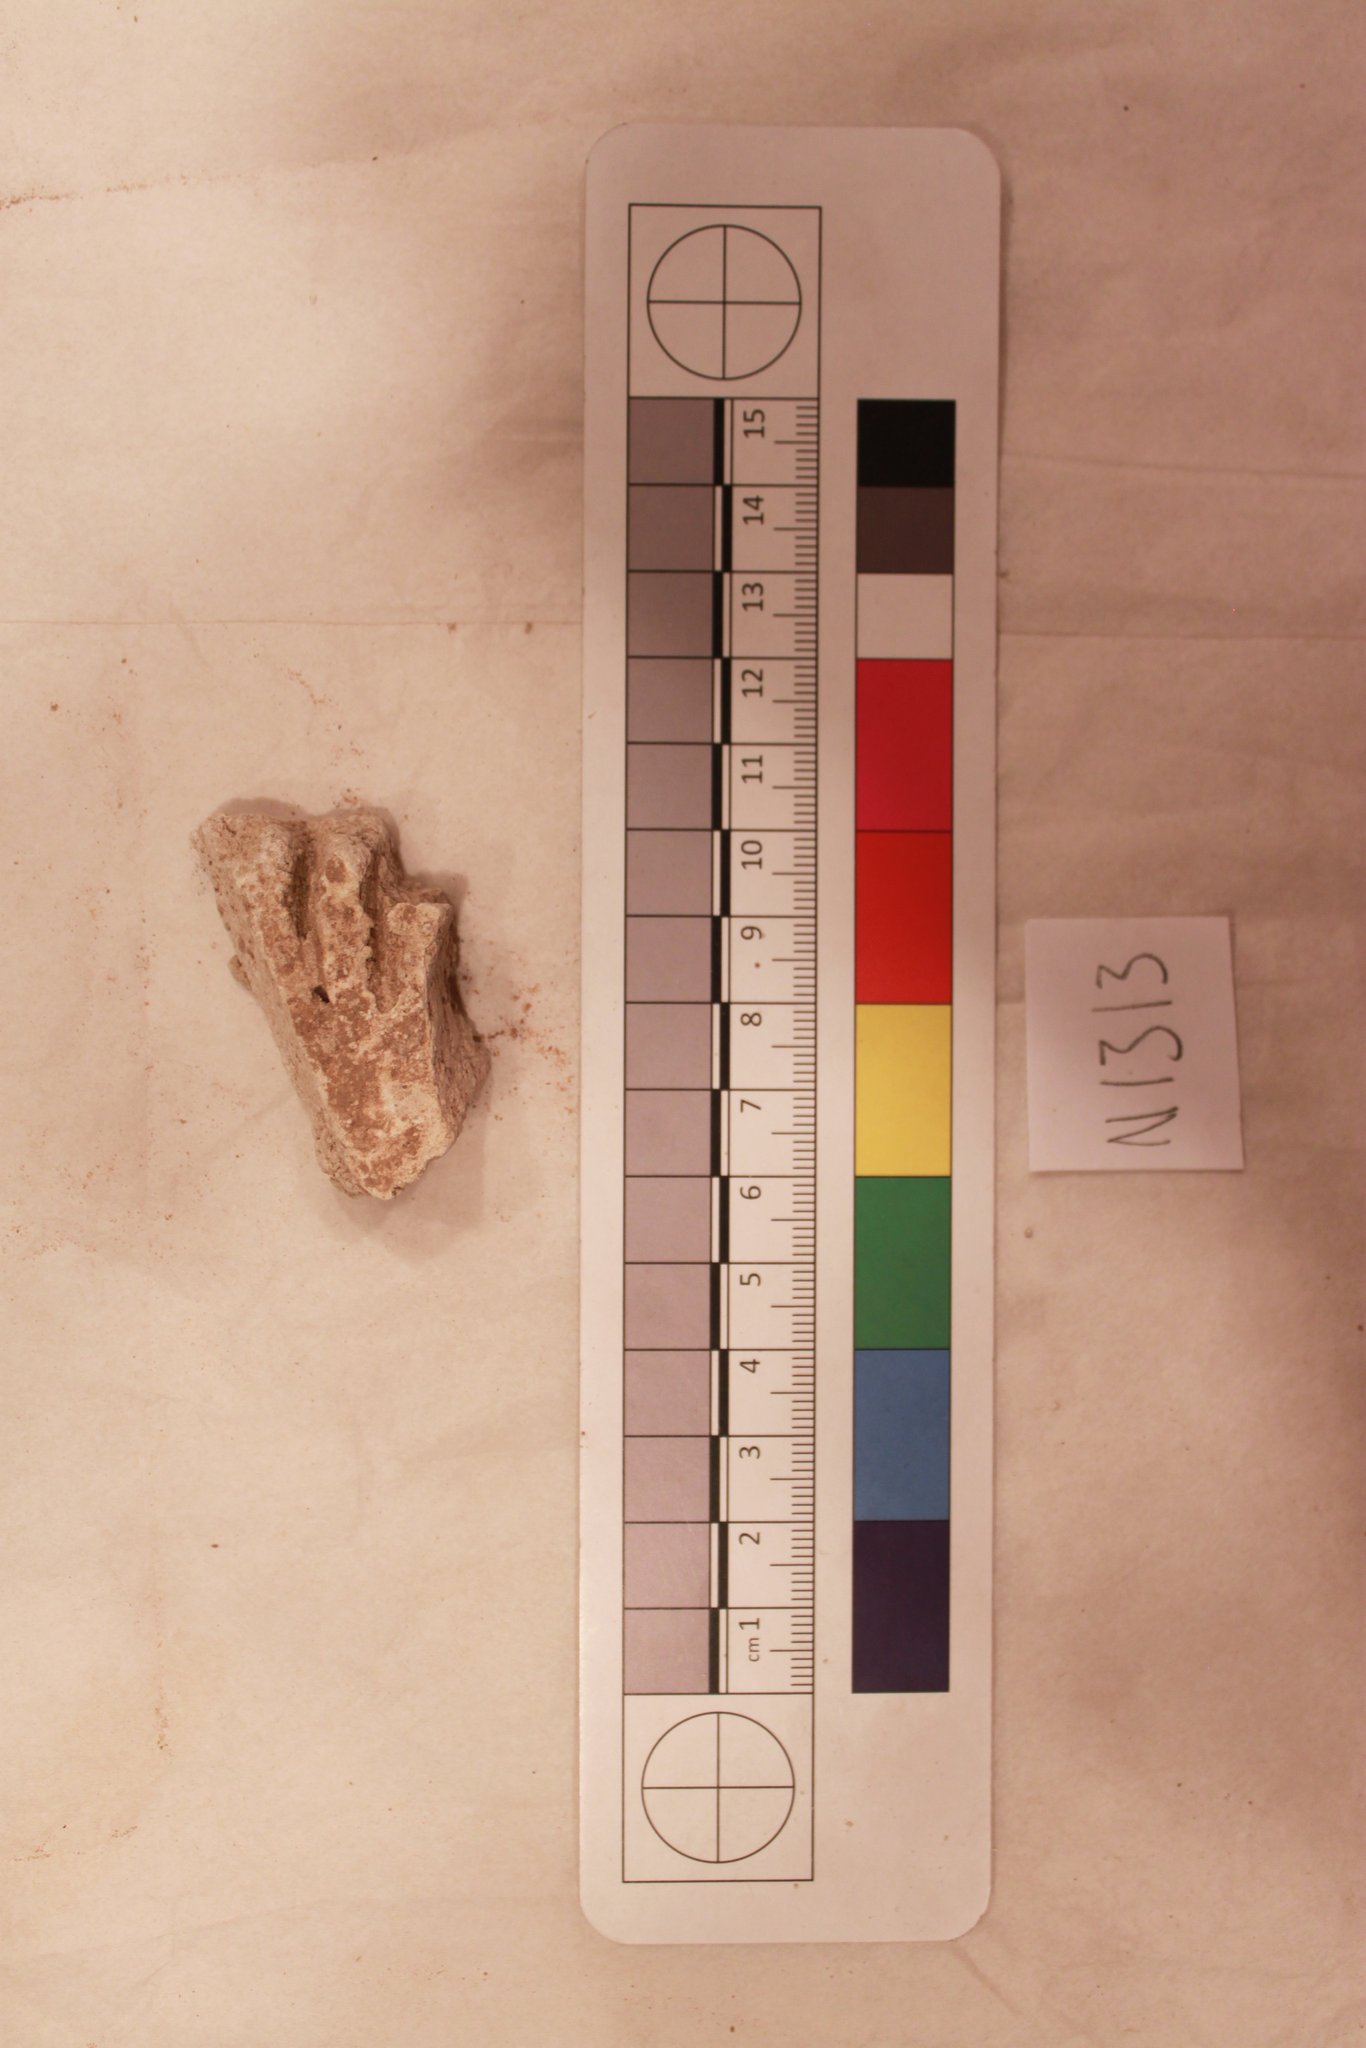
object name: fragment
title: Stucco Fragment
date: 701-1200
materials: plaster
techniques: carving, painting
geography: iran